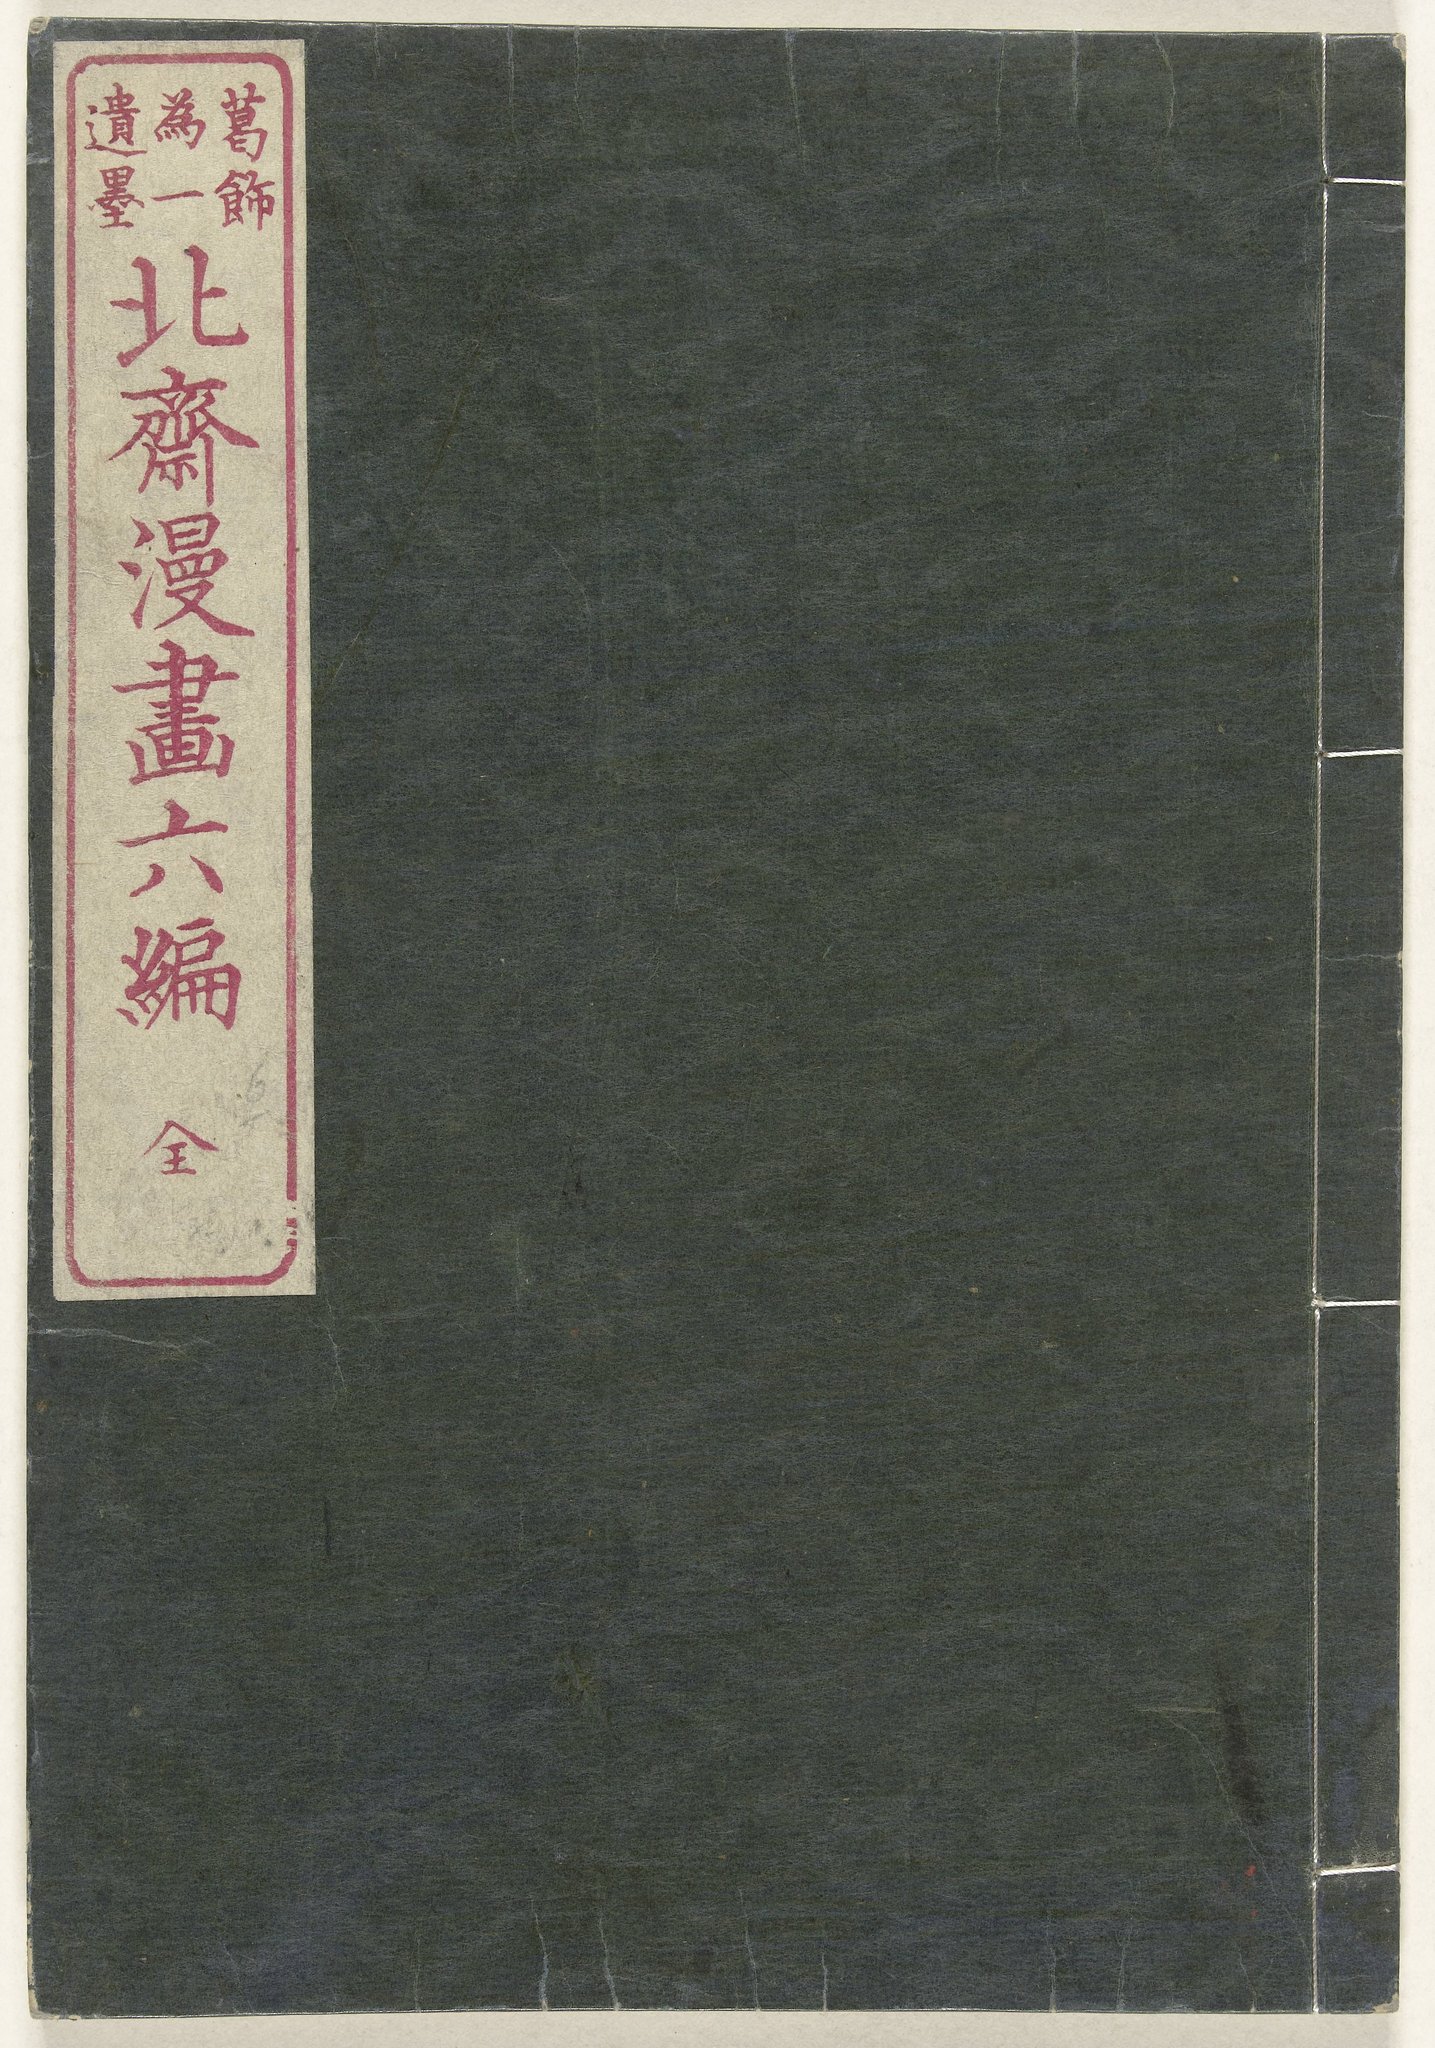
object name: book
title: Katsushika iitsu iboku Hokusai manga rokuhen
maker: katsushika hokusai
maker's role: draughtsman, print maker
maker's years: 1760-1849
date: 1878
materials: paper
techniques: woodcut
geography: tokyo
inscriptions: collector's mark: ‘Rijksschool voor kunstnijverheid’ Lugt 3937, collector's mark: Lugt 2228